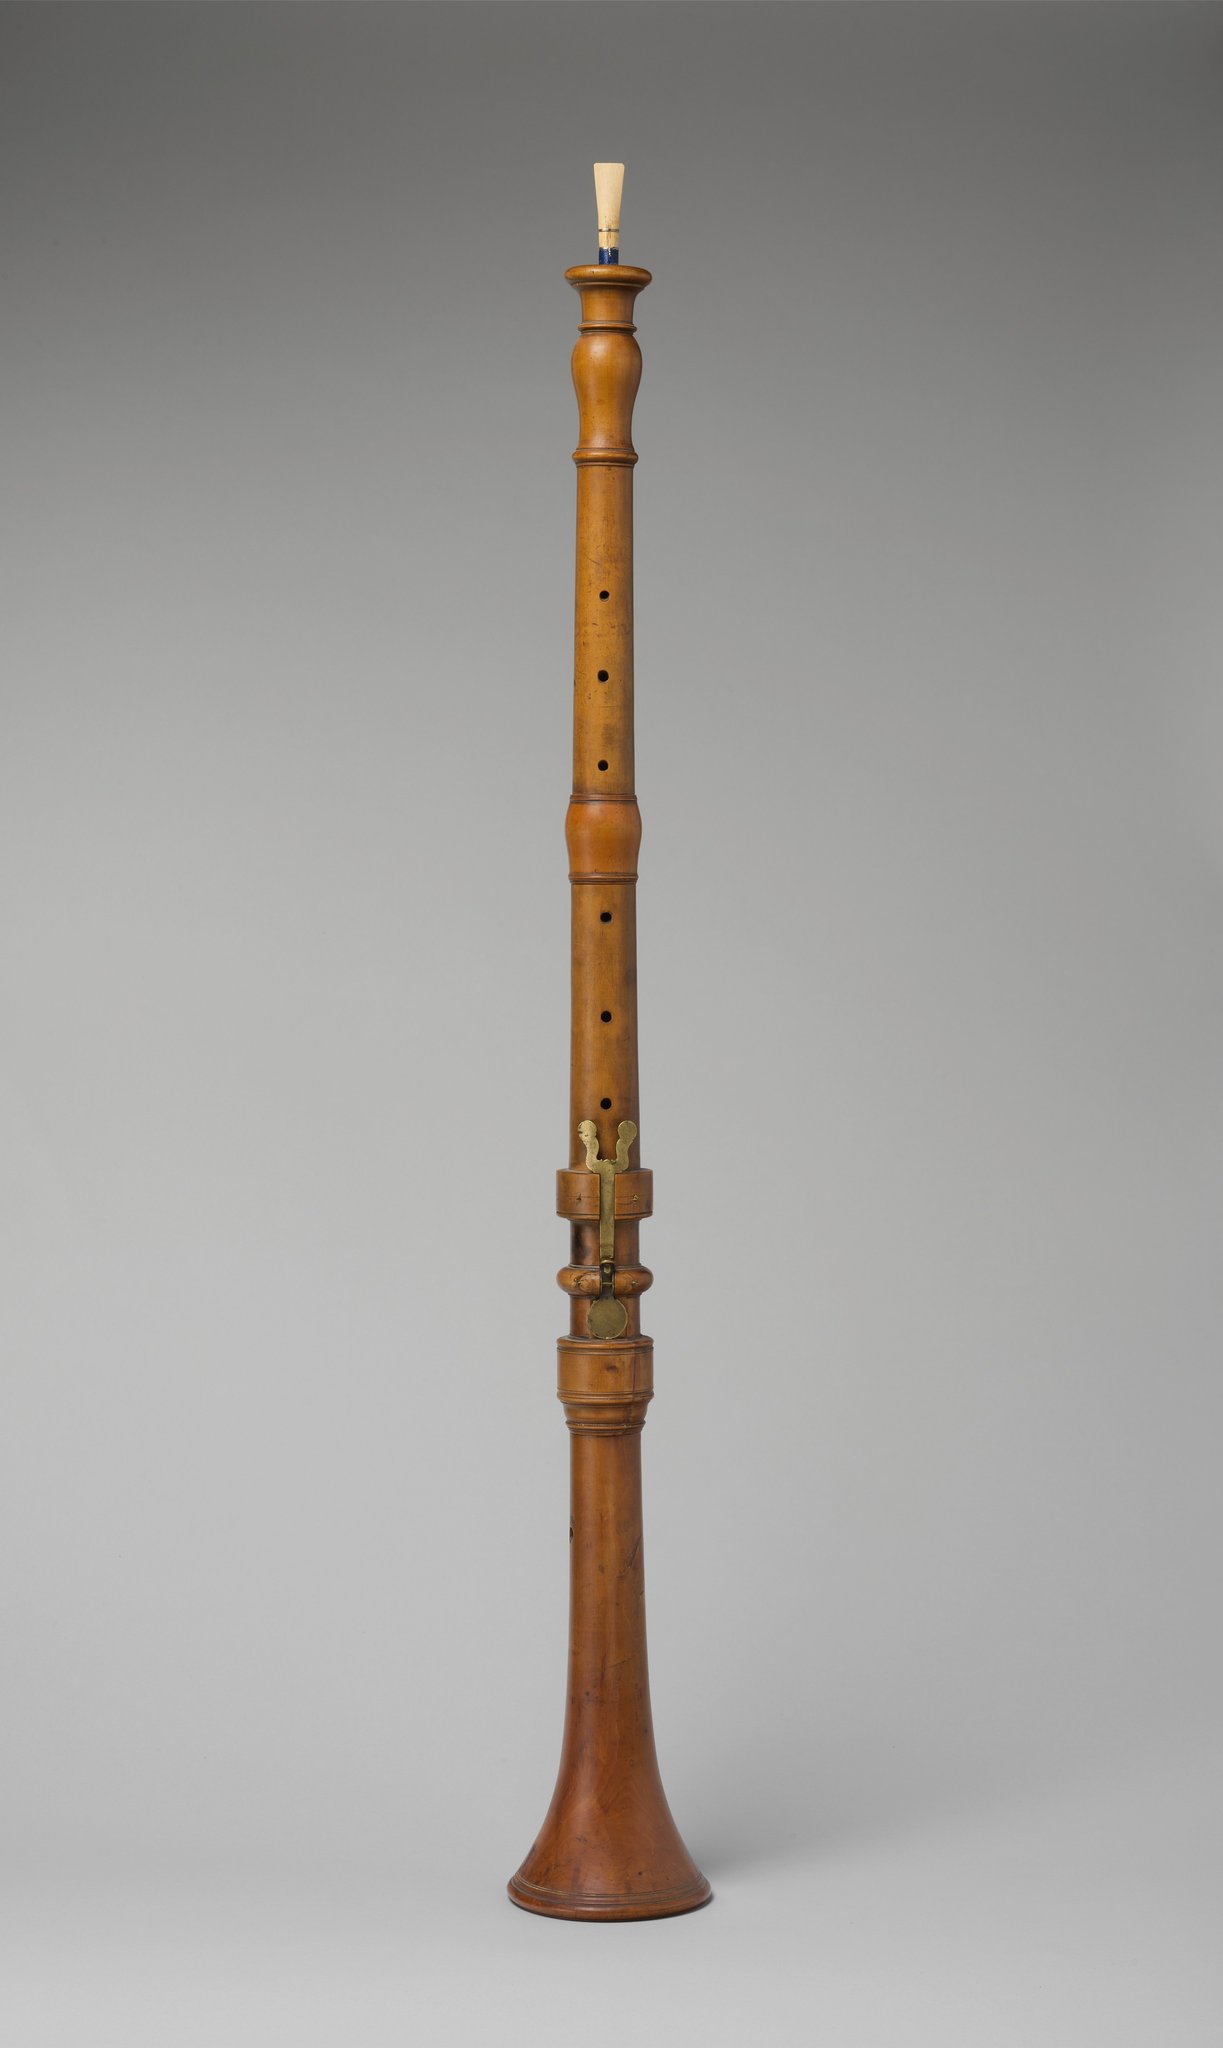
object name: grand oboe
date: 1650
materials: wood, brass